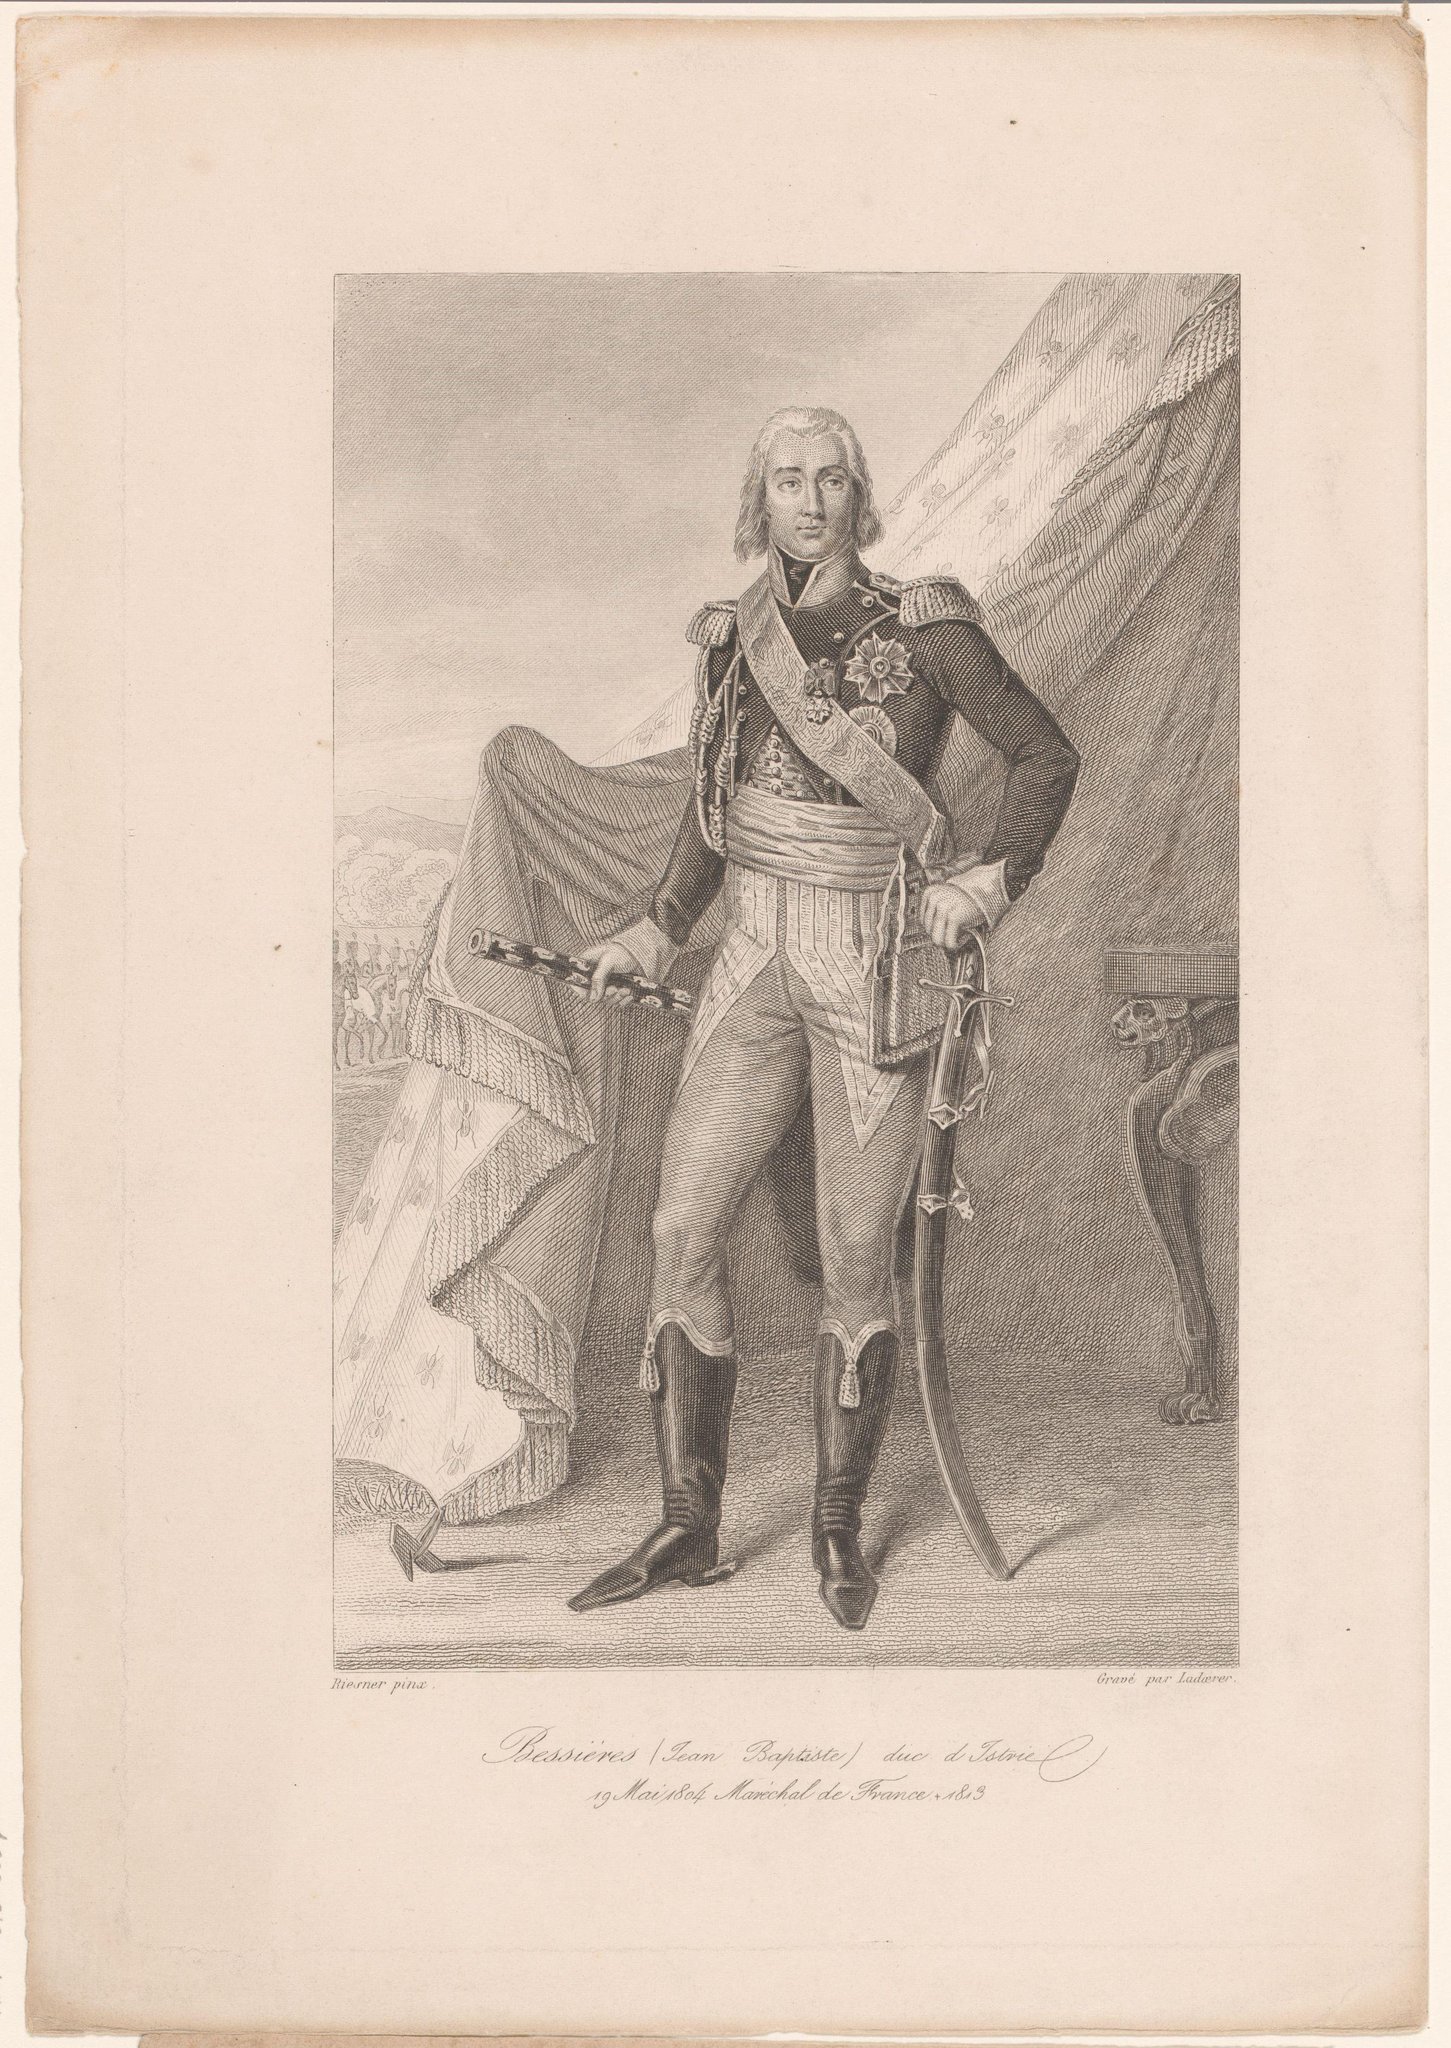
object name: print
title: Galeries Historiques de Versailles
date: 1831-1841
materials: paper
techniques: etching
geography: france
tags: (military) camp with tents, commander-in-chief, general, marshal, historical persons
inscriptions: collector's mark: Lugt 2228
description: Prent uit: Galeries historiques de Versailles. Parijs: Charles Gavard, 1838-1841.